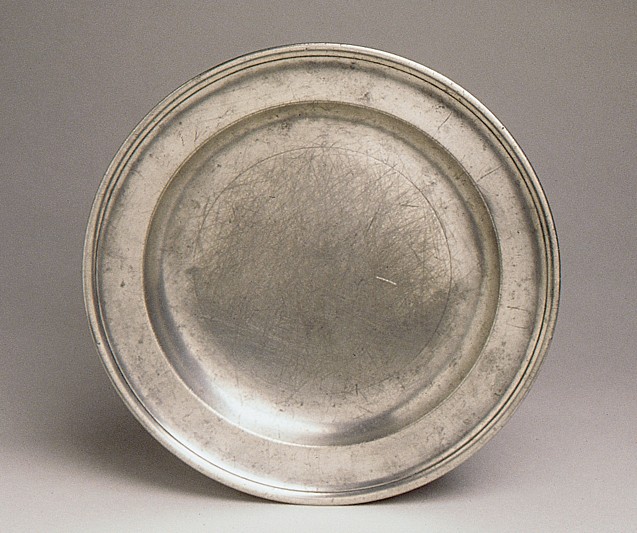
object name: plate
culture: american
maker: francis bassett, i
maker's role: maker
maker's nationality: american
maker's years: 1690-1758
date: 1750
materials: pewter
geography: united states